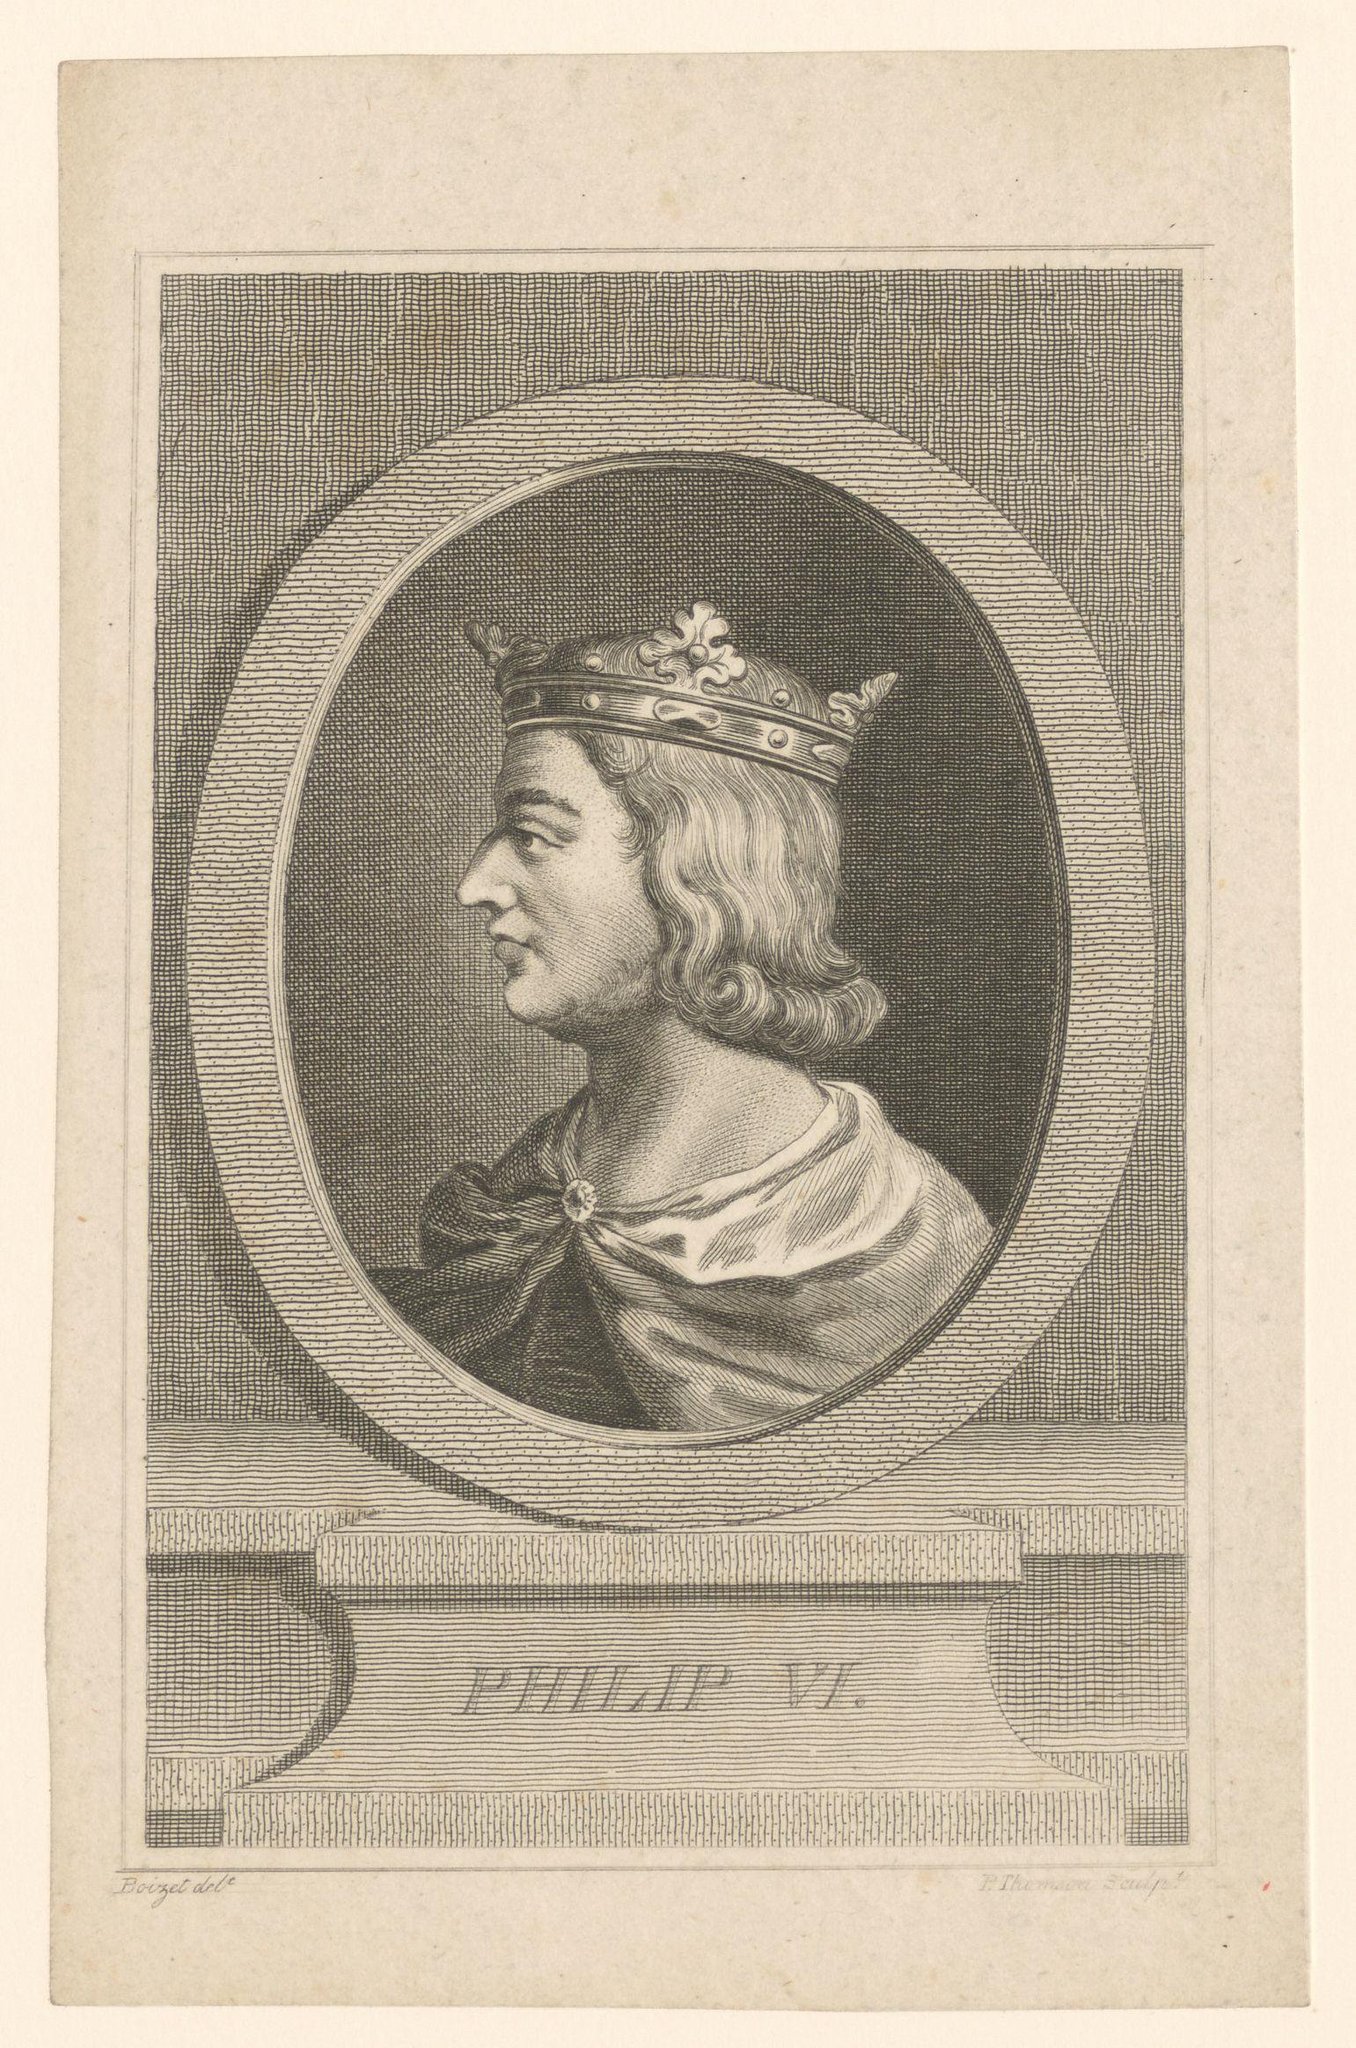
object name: print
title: Portret van Filips VI van Frankrijk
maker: paton thomson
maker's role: print maker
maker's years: 1750-1821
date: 1760-1821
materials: paper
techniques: etching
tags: historical persons, king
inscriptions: collector's mark: Lugt 2228